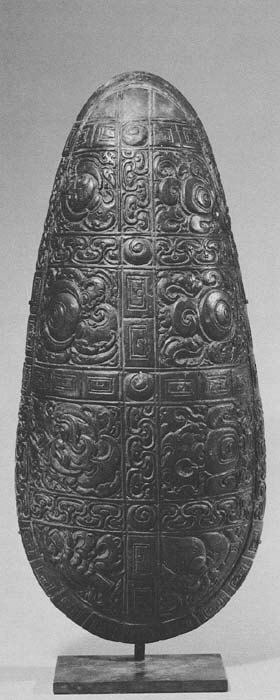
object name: lid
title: Decorated Lid(?)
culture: indonesian, javanese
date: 1101-1400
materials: bronze